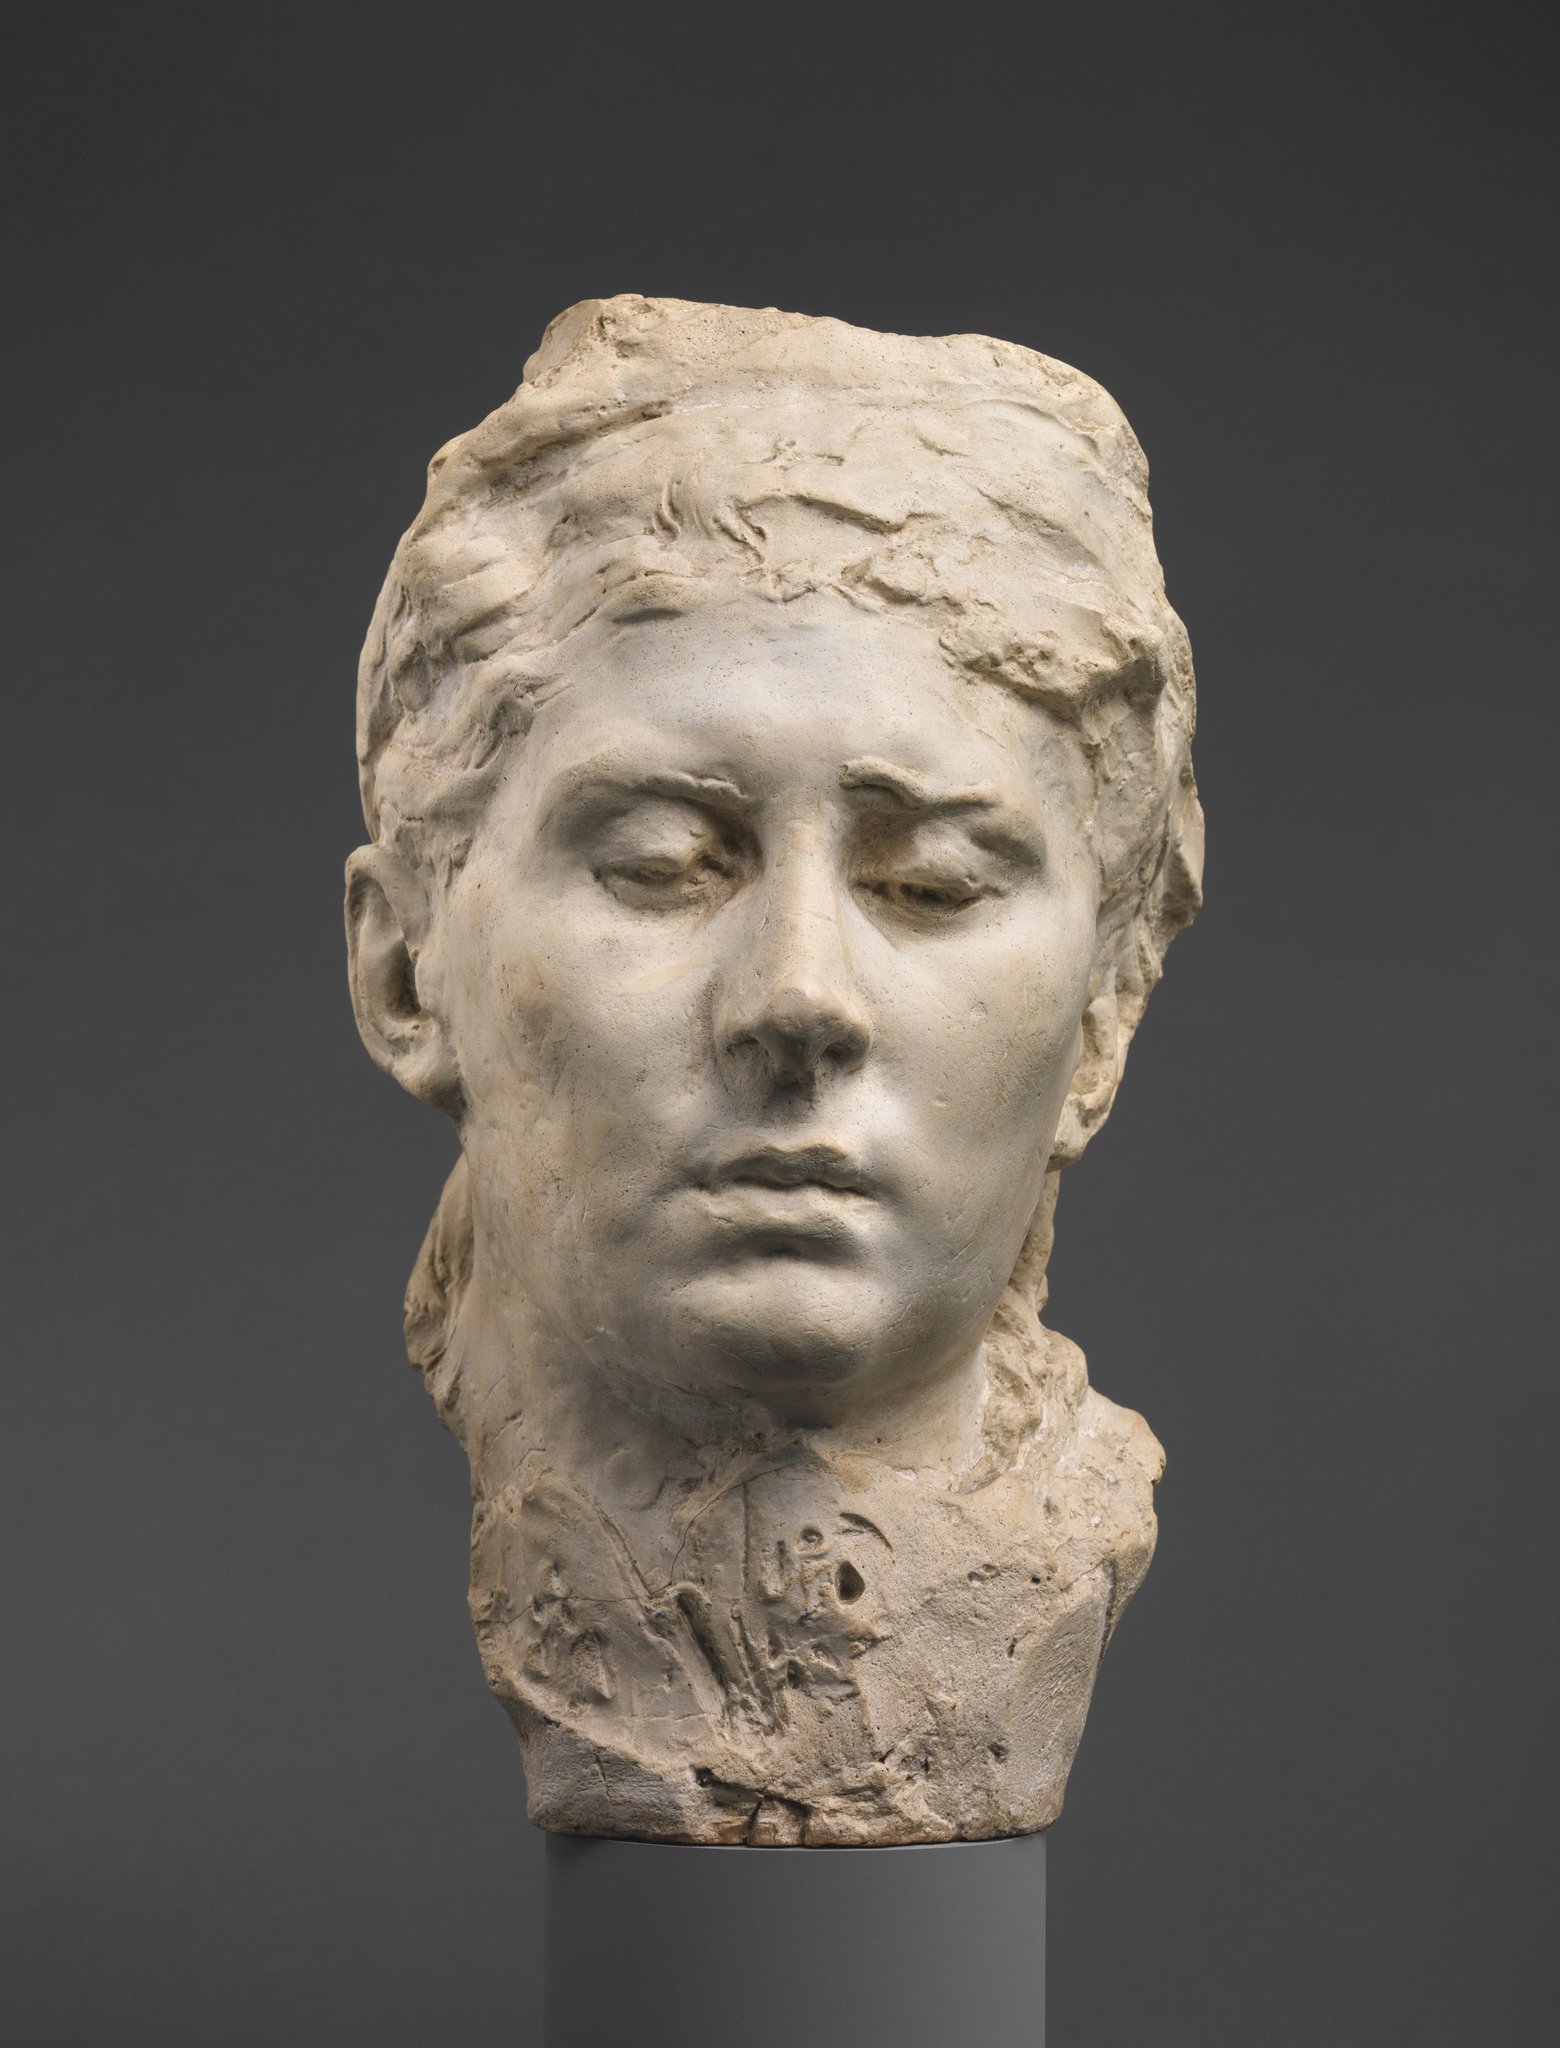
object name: bust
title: Mask of Rose Beuret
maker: auguste rodin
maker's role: artist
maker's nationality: french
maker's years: 1840-1917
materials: plaster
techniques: casting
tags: masks